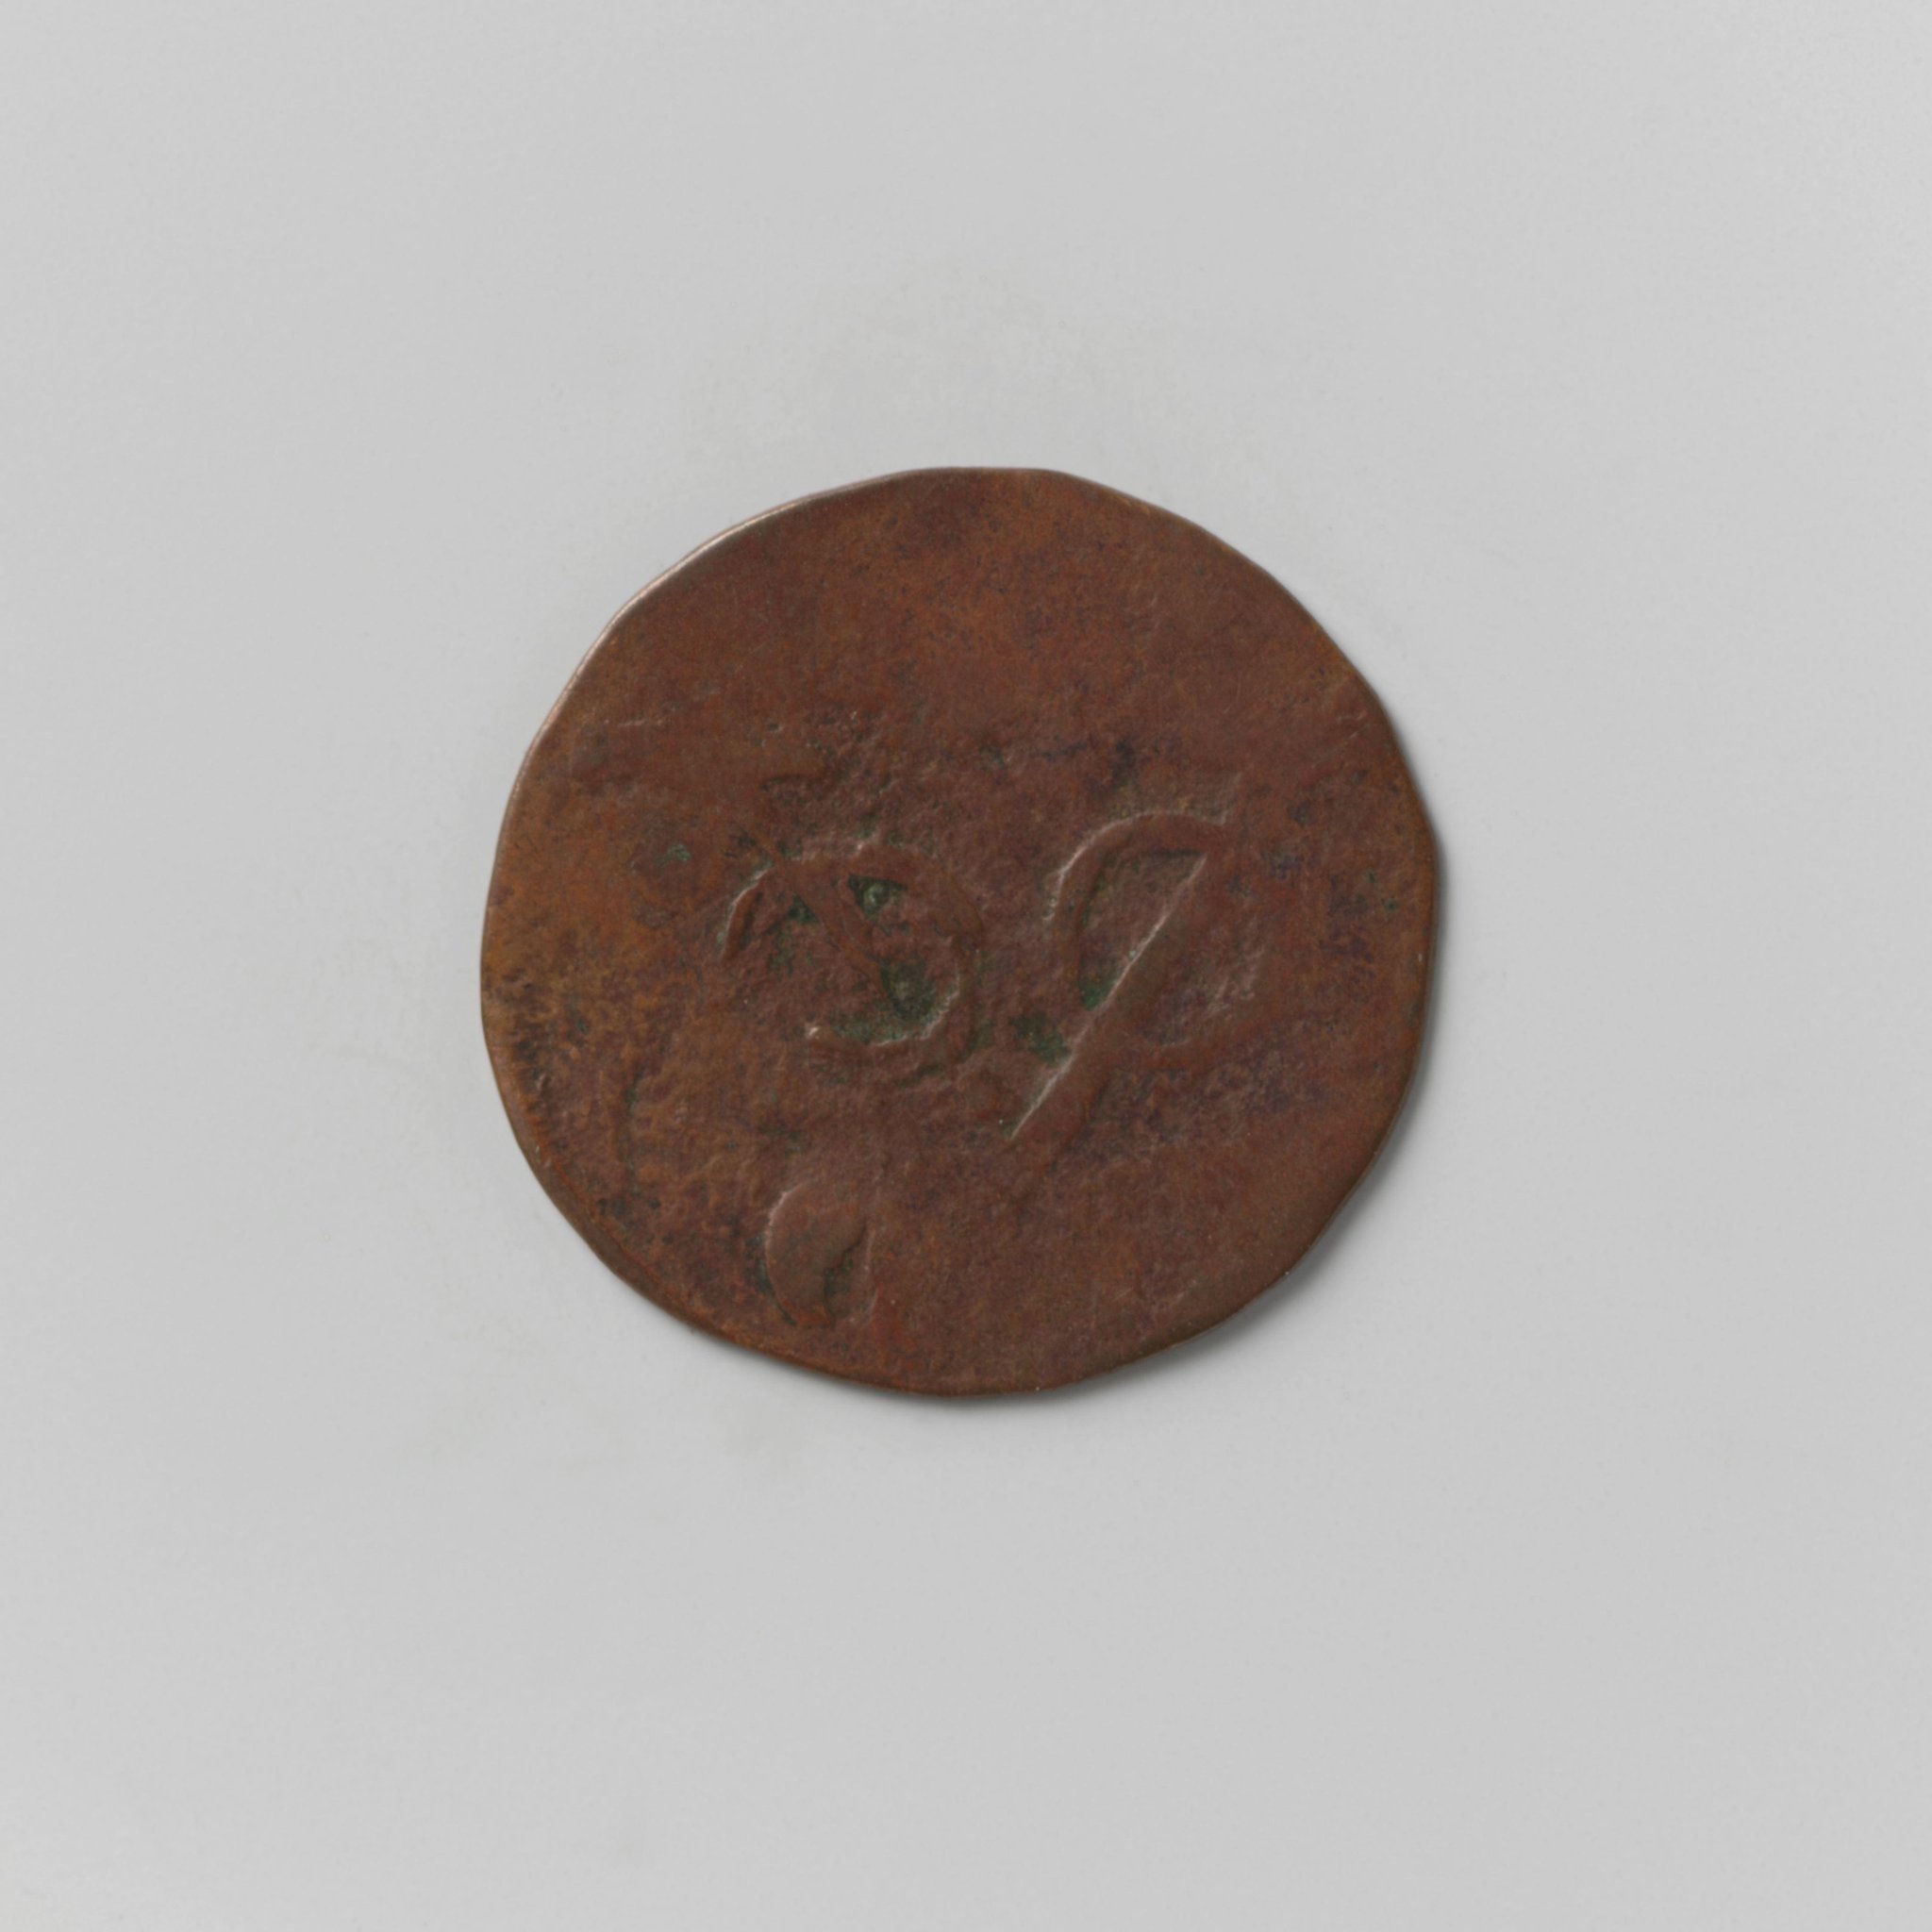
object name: coin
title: Nabootsing van VOC- duit West-Friesland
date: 1780-1830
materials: copper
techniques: striking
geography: banjarmasin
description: Koperen munt. Nabootsing van duit van de VOC uit West-Friesland. Voorzijde: gekroond wapenschild van West-Friesland. Keerzijde: monogram van de VOC, waaronder fictief jaartal.